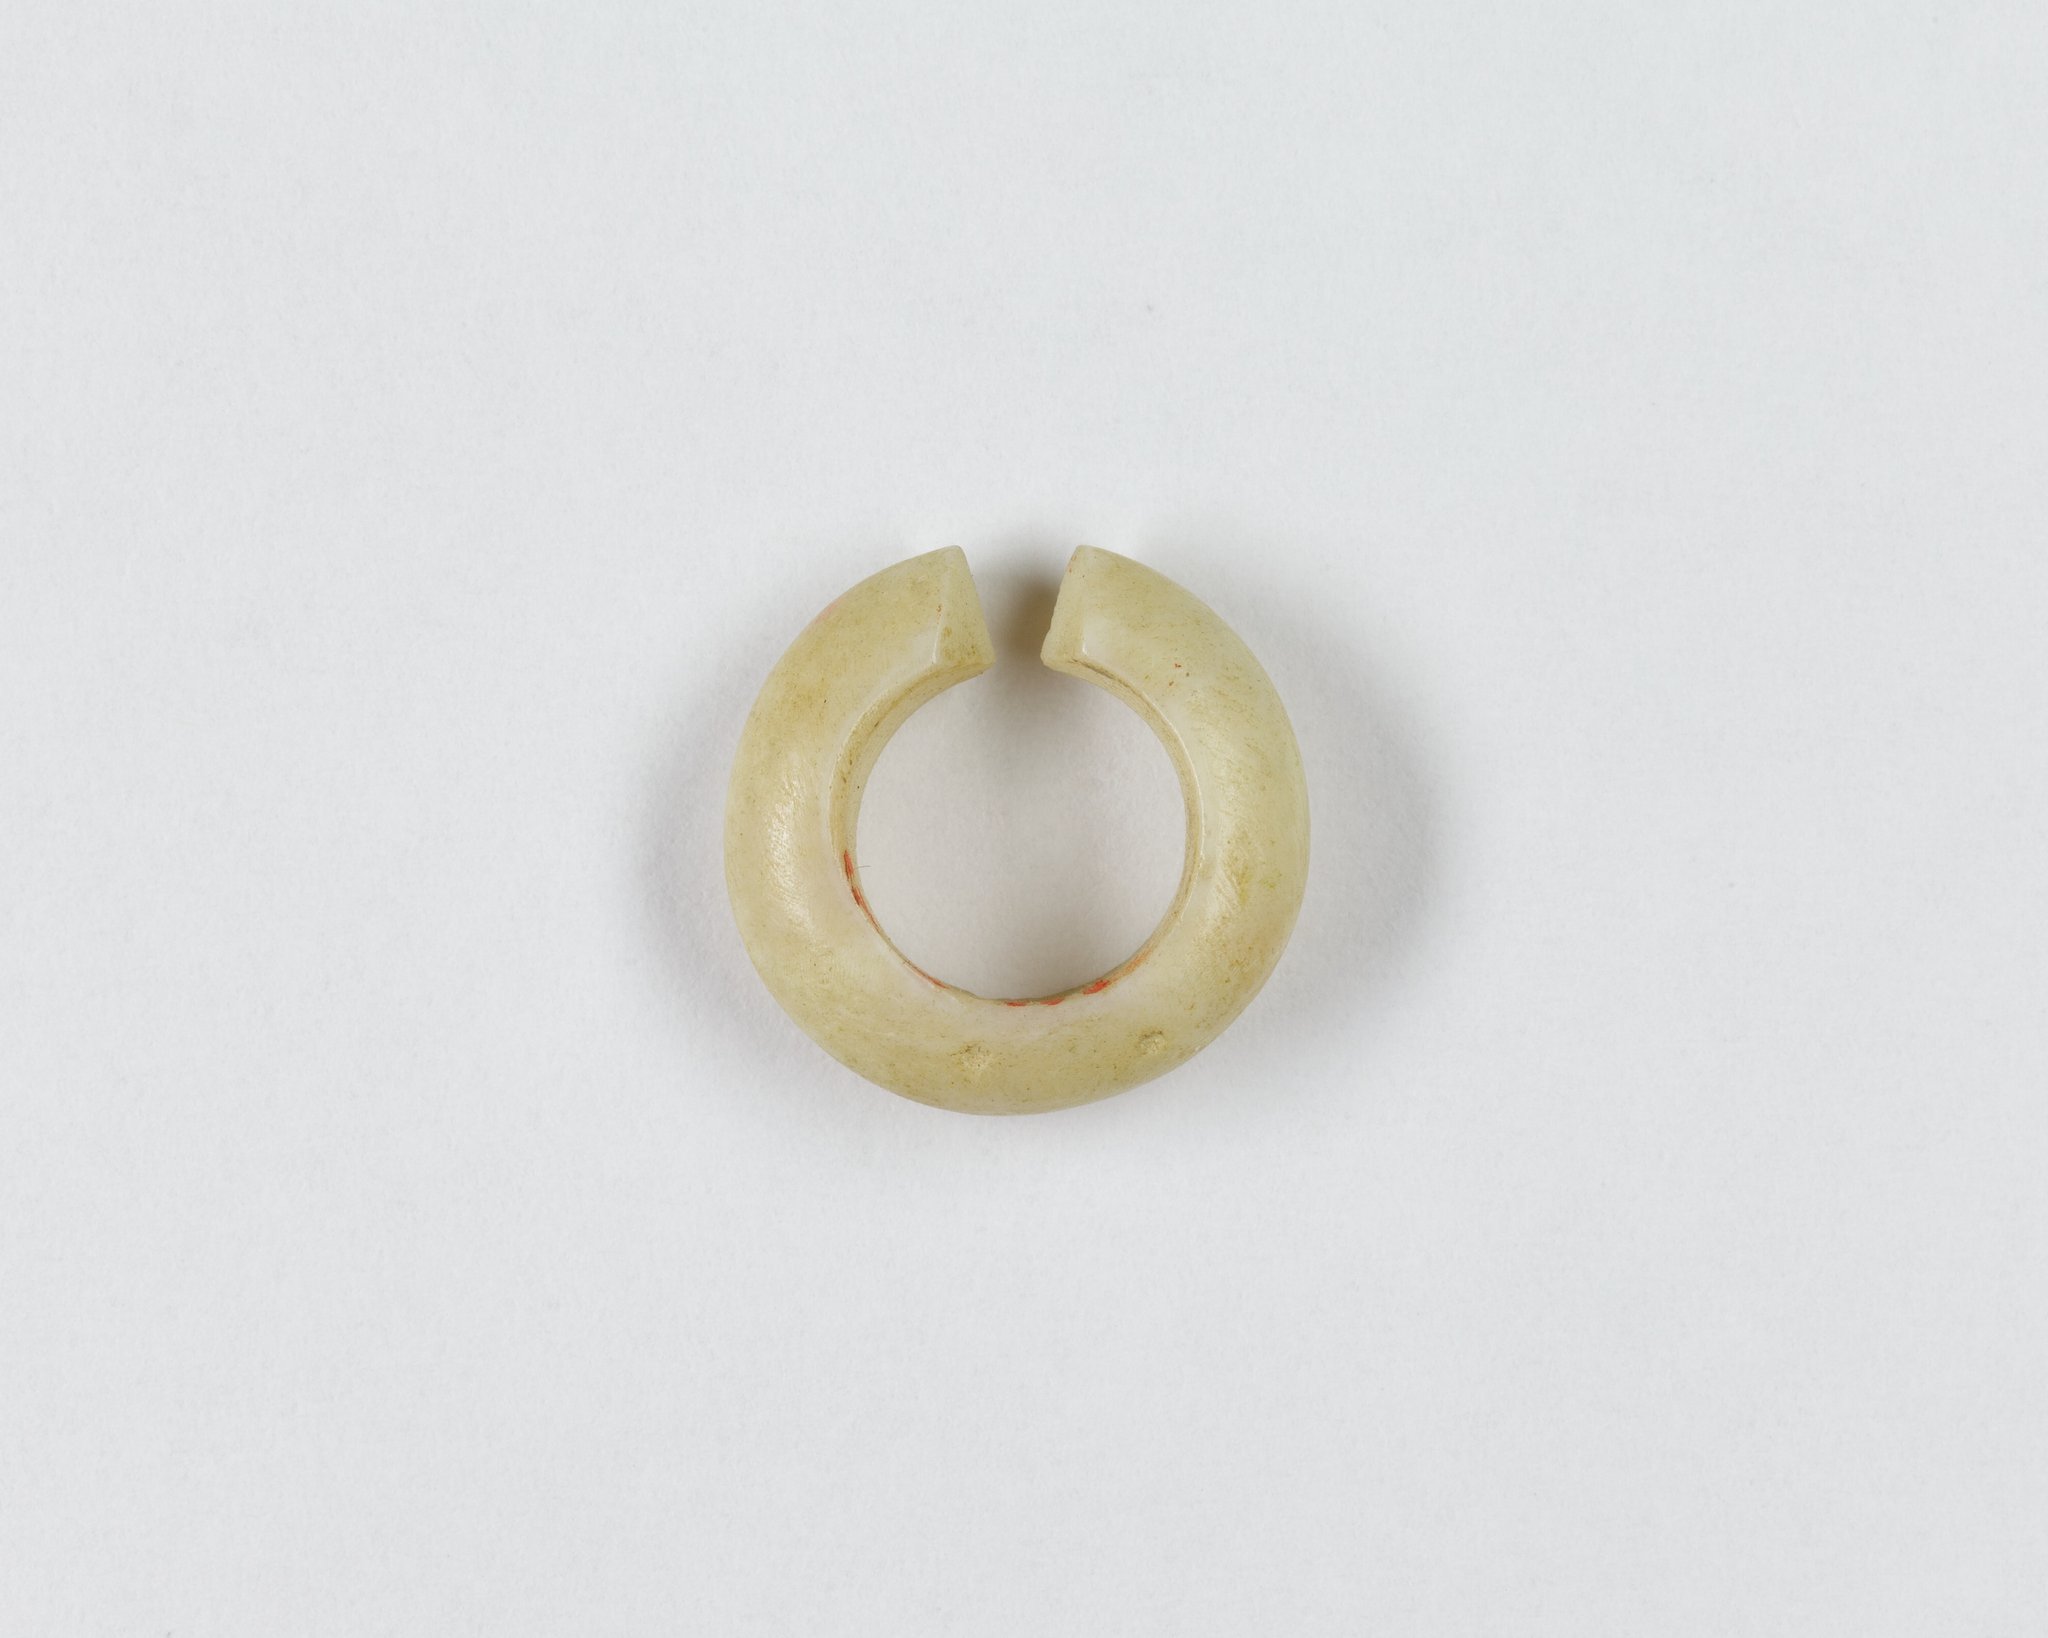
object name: earring, penannular, circular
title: Penannular Earring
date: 1550-1295 BCE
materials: shell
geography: northern upper egypt